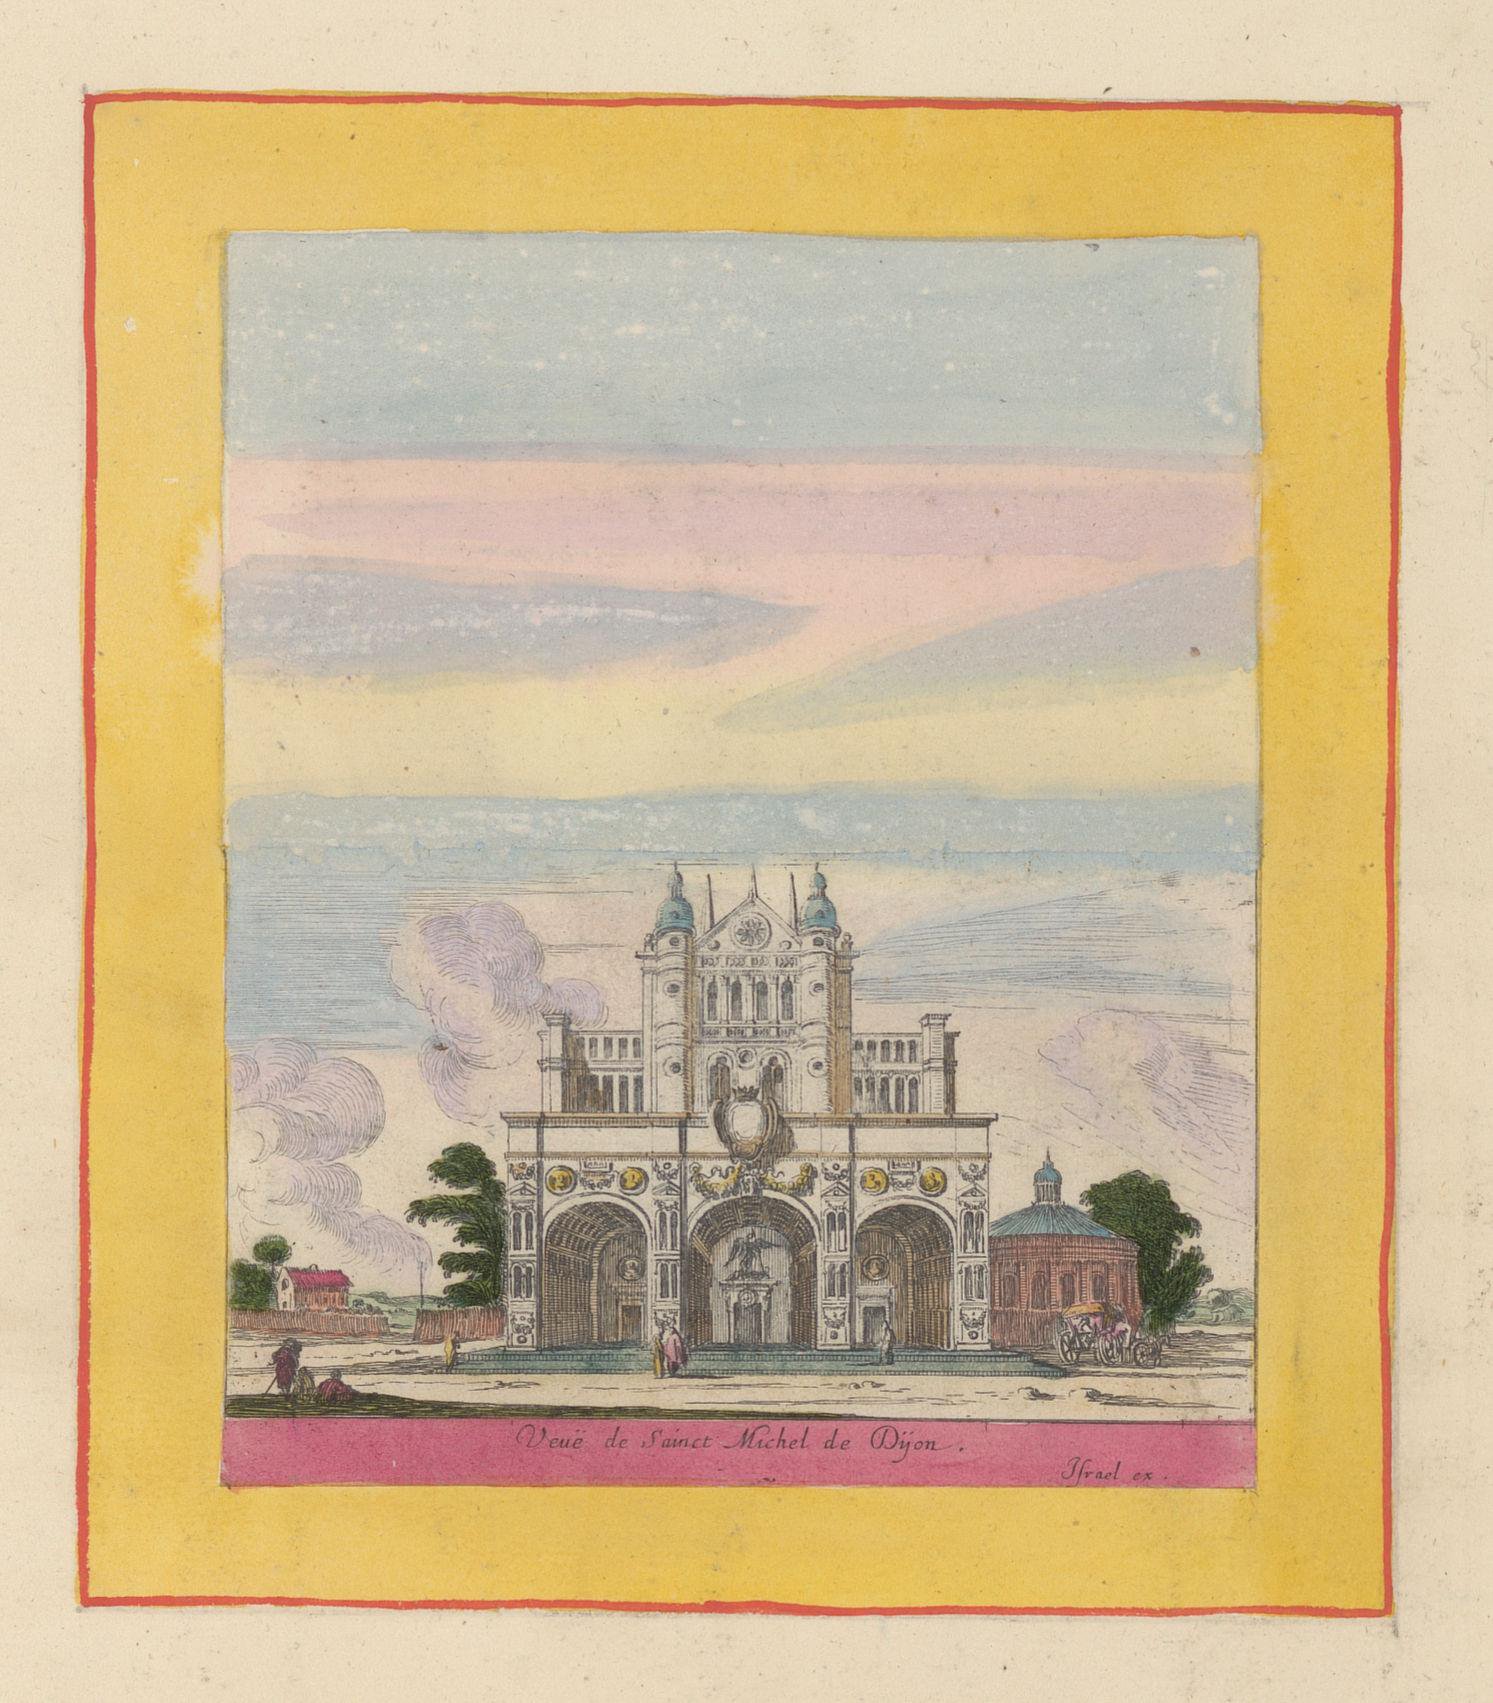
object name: print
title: Gezicht op de façade van de Saint-Michel in Dijon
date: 1631-1691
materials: paper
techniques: etching, hand coloring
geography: the hague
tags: city-view in general; 'veduta', church (exterior)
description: Deze prent maakt deel uit van een album.